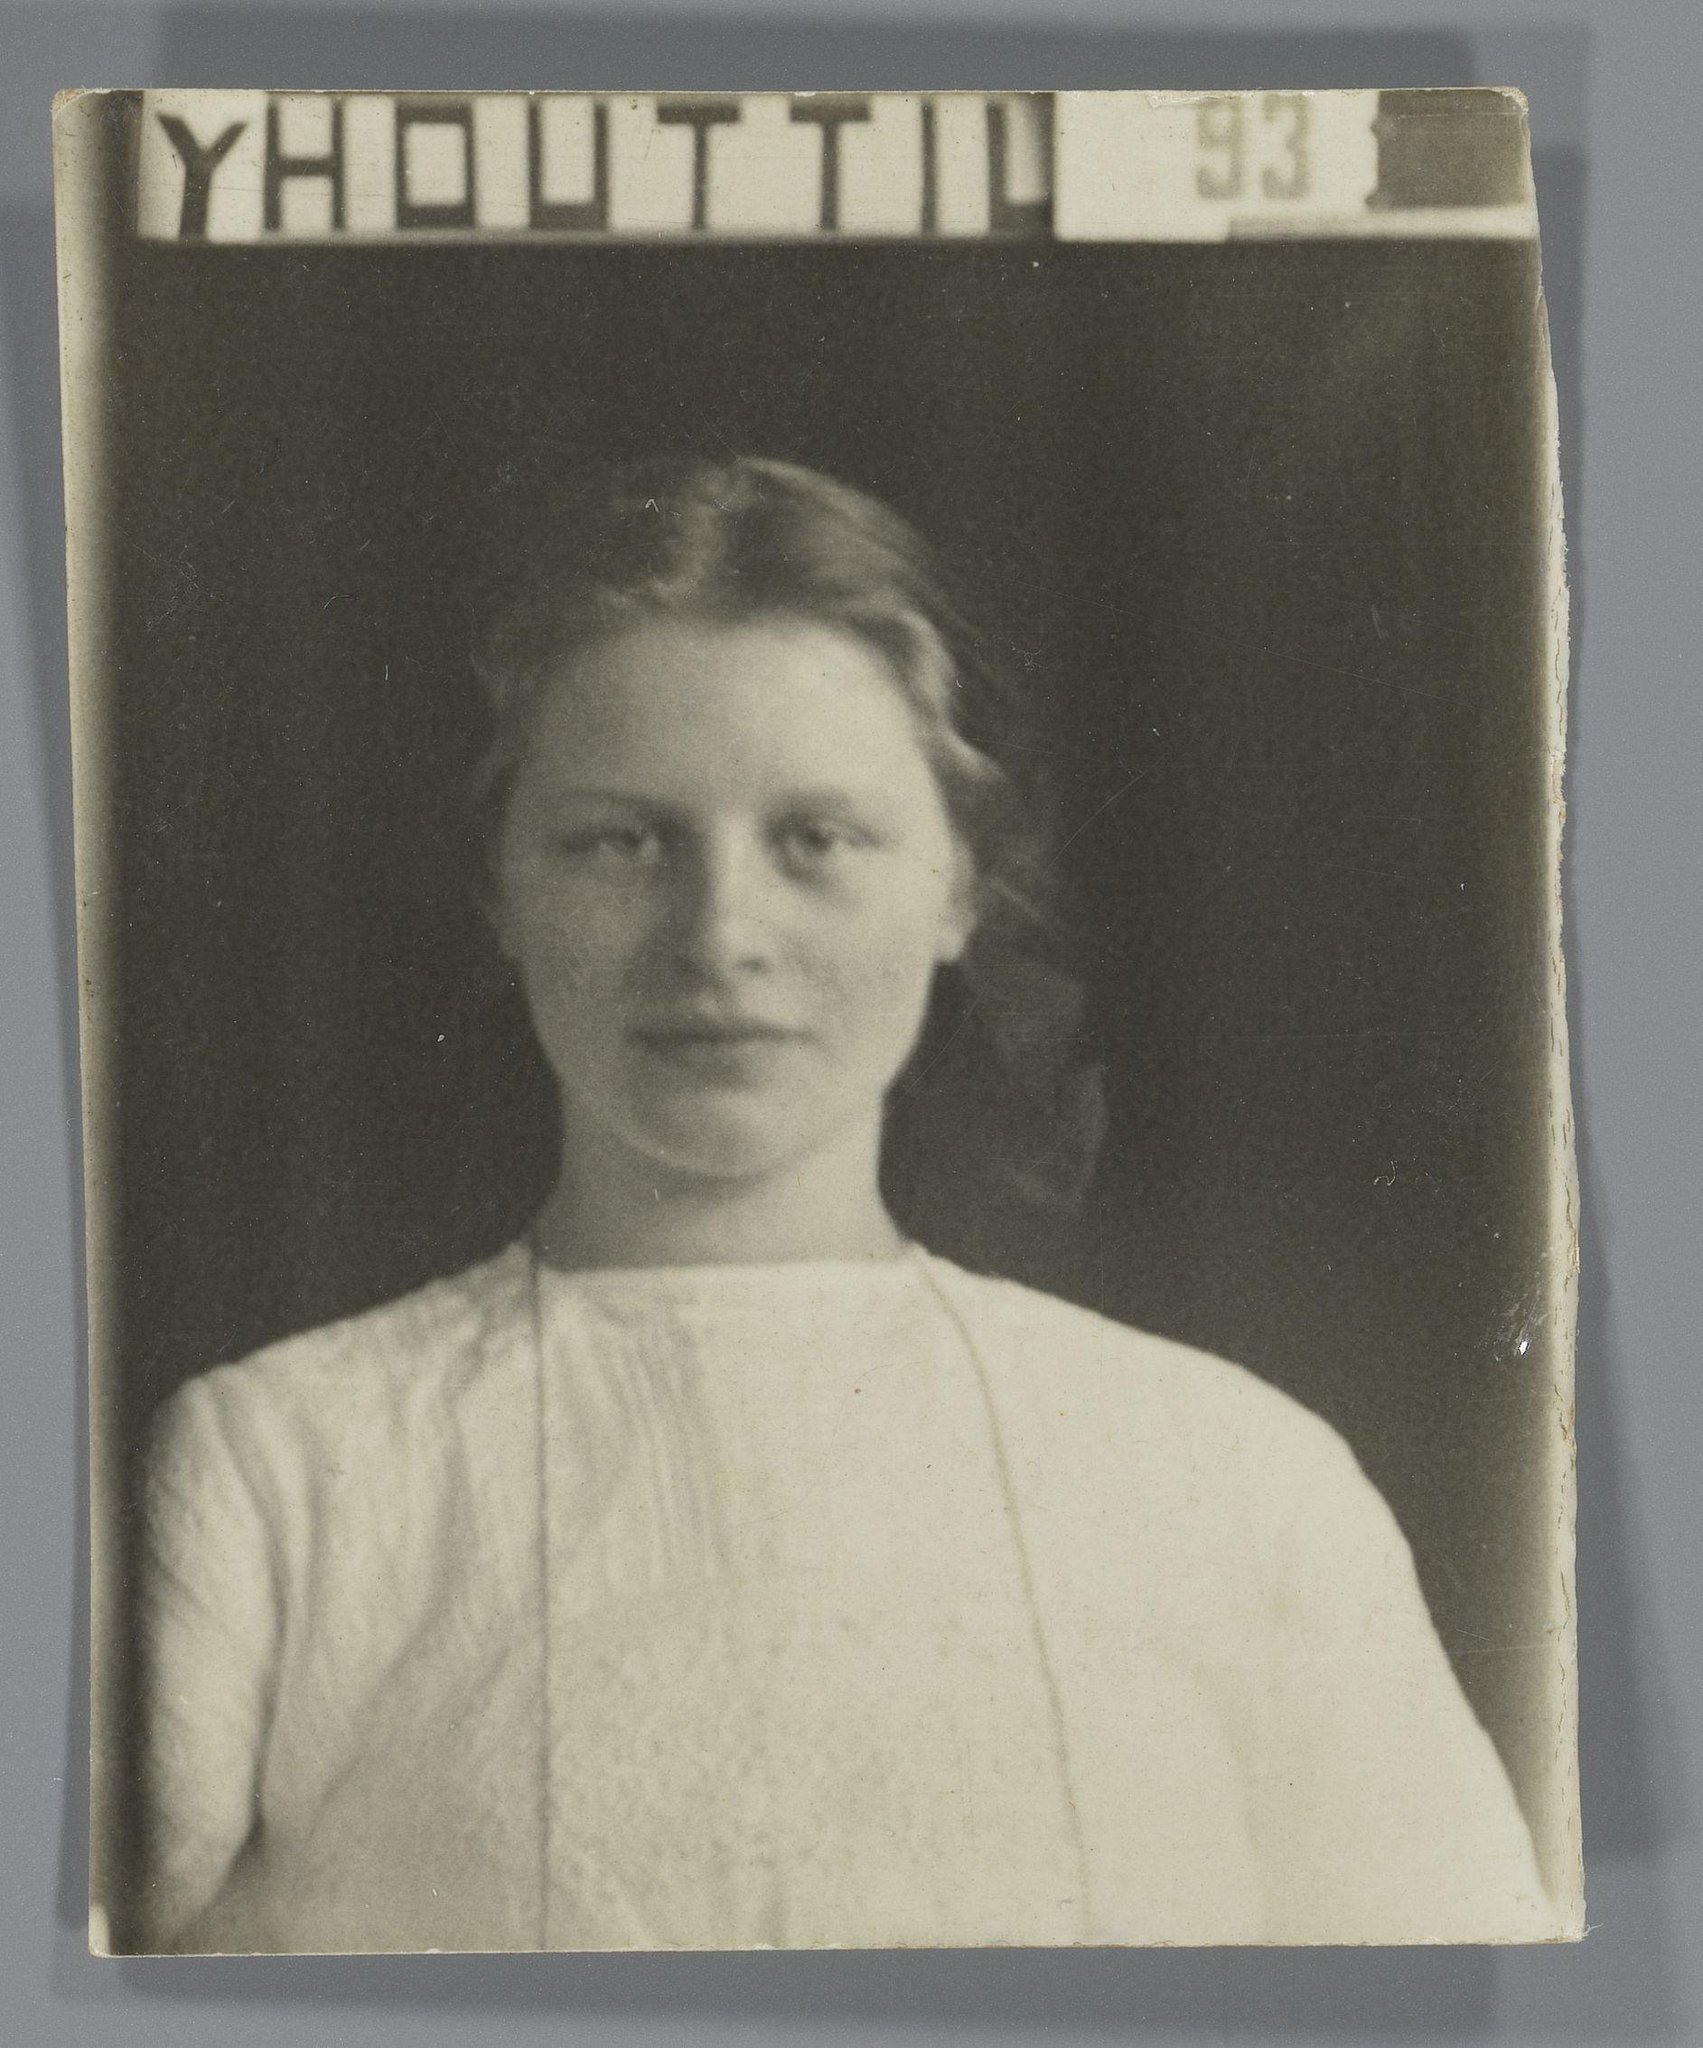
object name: snapshot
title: Rapid photographs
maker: jan gottfried stütner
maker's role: fotograaf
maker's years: 1892-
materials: photographic support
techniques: gelatin silver print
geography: alkmaar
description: Between 1912 and 1930, anyone could have their portrait taken at the many so-called rapid photography studios in the shopping streets of mainly (medium) large-size European cities. As if on an assembly line, the youngest clerk shot the photographs with a special camera and in artificial light and developed them. Later in the day, the customer collected a sheet with 12 portrait photos for 25 cents. This form of photographic mass production gave rise to a fascinating tableau of boys, girls, men and women not previously seen in photographs; candid and informal. There were at least 150 quick-photo studios, from Alkmaar to Zutphen. Many called themselves ‘American,’ mistakenly as it turns out because hardly any examples from that country have been found.